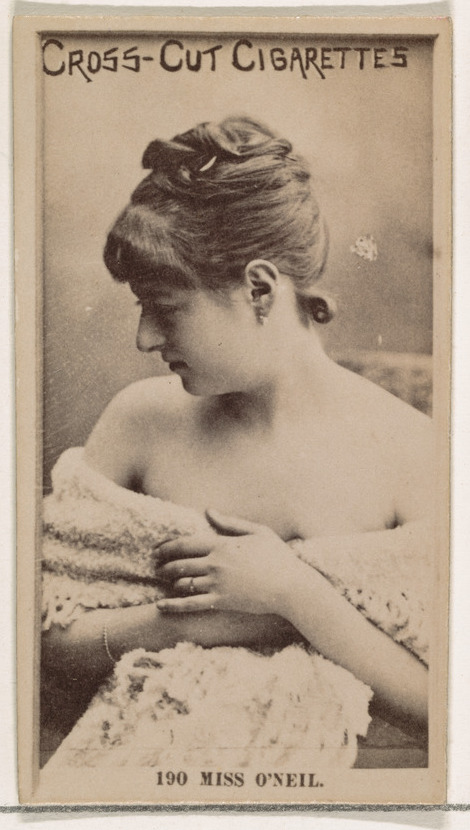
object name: print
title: Card Number 190, Miss O'Neil, from the Actors and Actresses series (N145-2) issued by Duke Sons & Co. to promote Cross Cut Cigarettes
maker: w. duke, sons & co.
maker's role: publisher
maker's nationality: american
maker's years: 1870-1920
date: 1880-1889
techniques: albumen silver print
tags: portraits,women,actresses